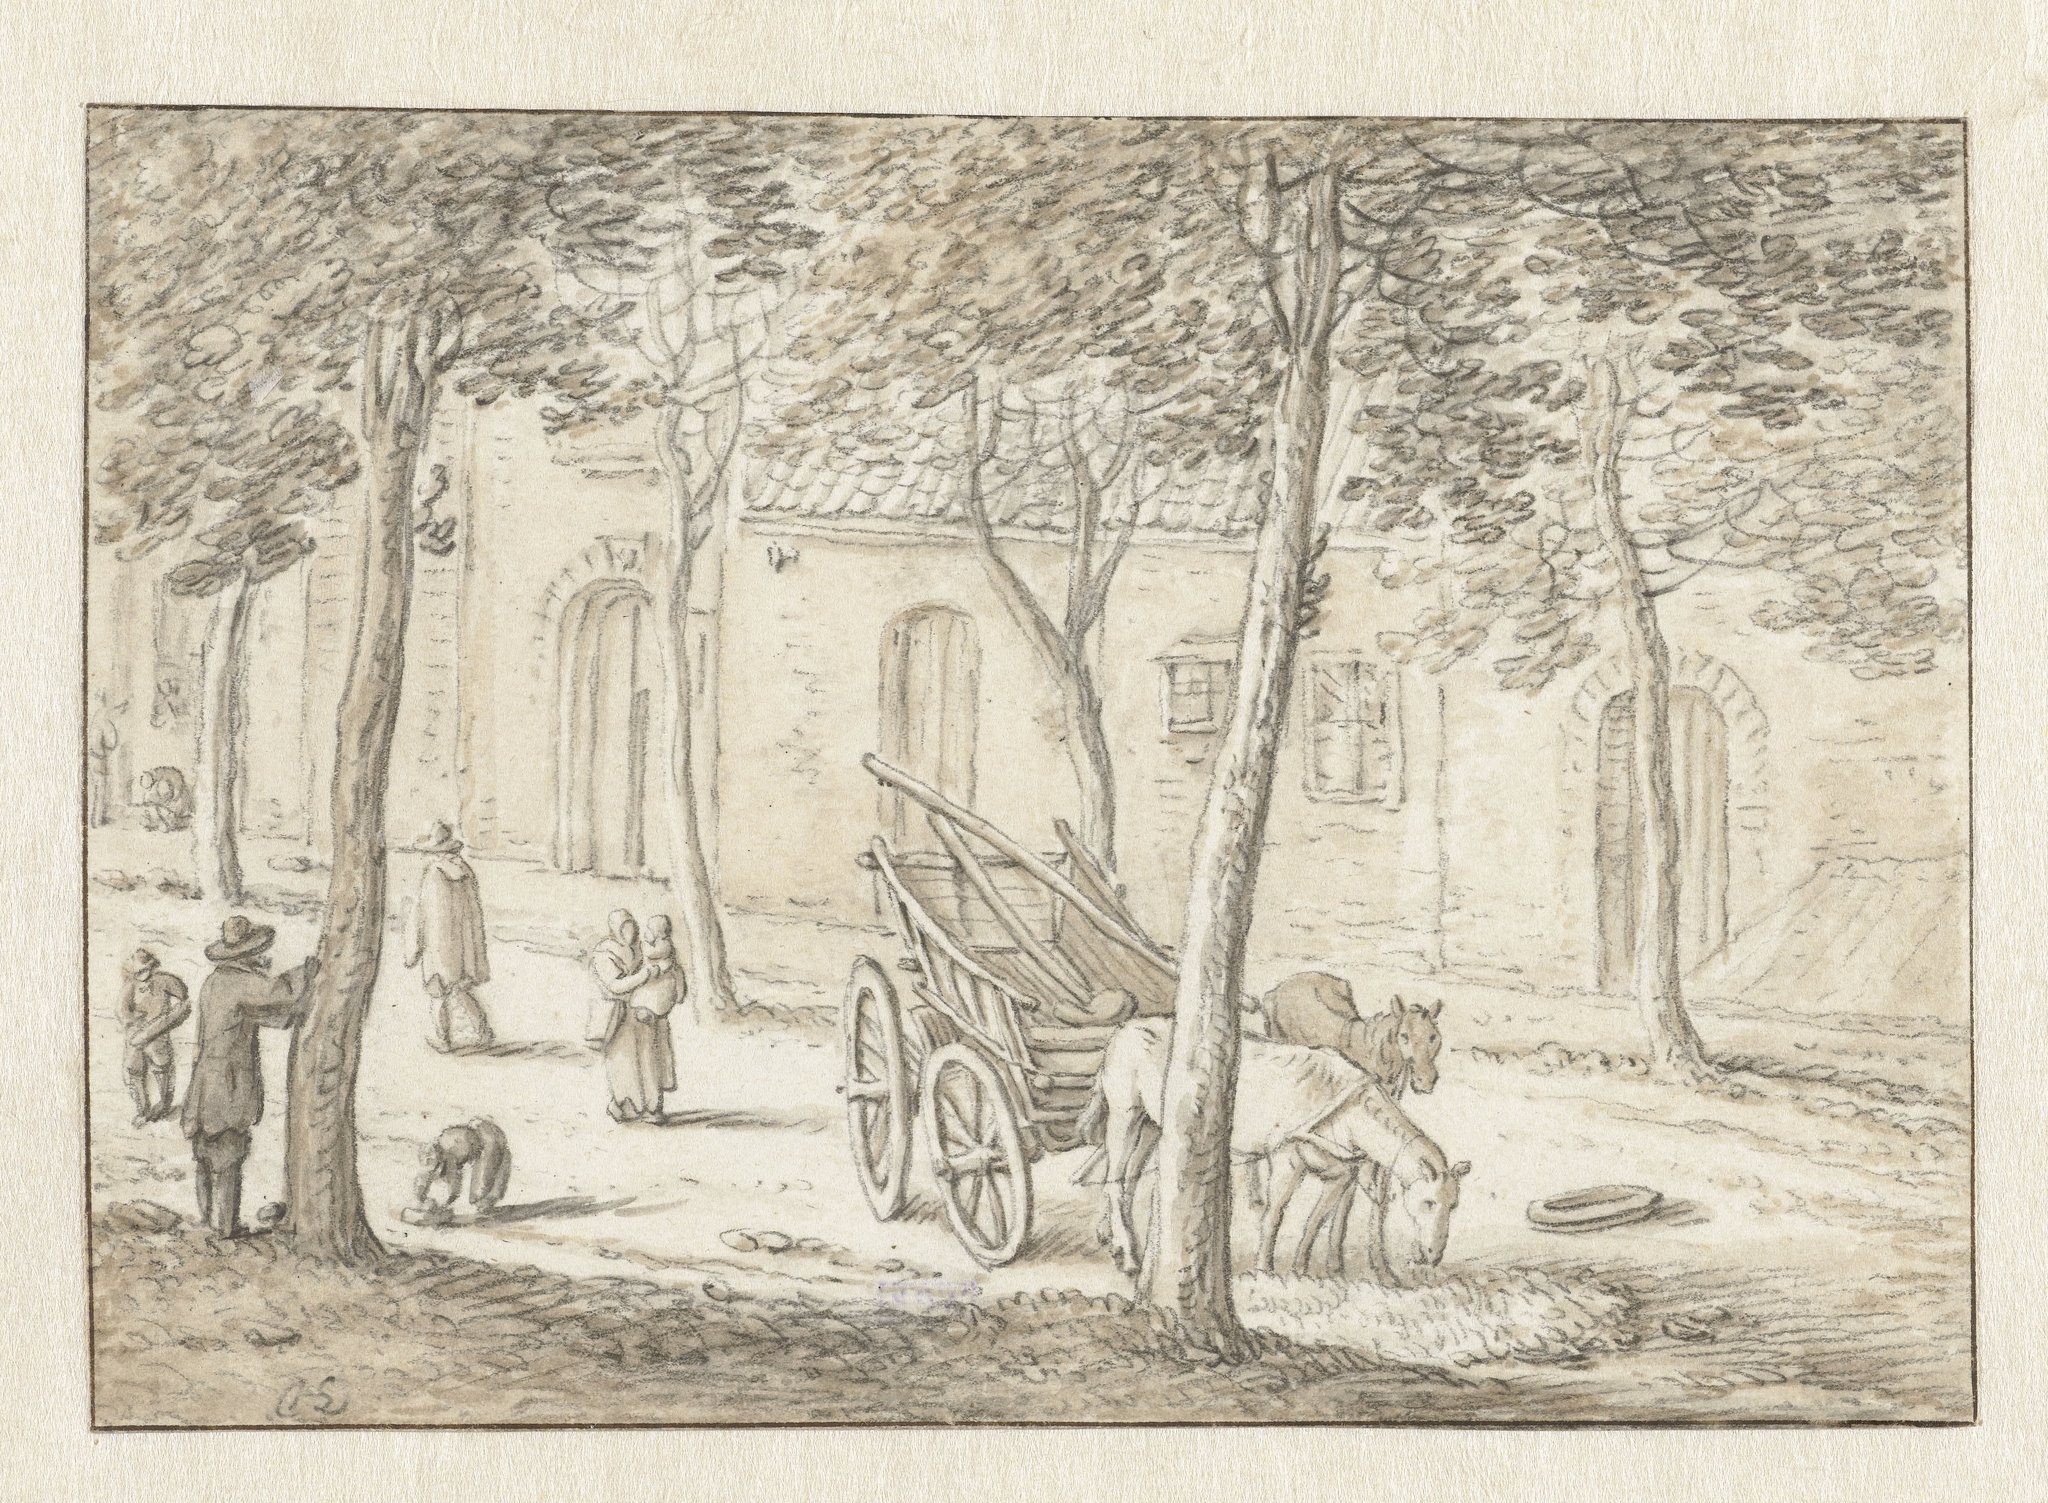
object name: drawing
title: Pieterskerkhof te Utrecht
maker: herman saftleven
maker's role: draughtsman, painter, print maker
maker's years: 1609-1685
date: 1619-1685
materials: chalk, paper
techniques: brush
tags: church (exterior), (farm) wagon, freight wagon, cart, utrecht